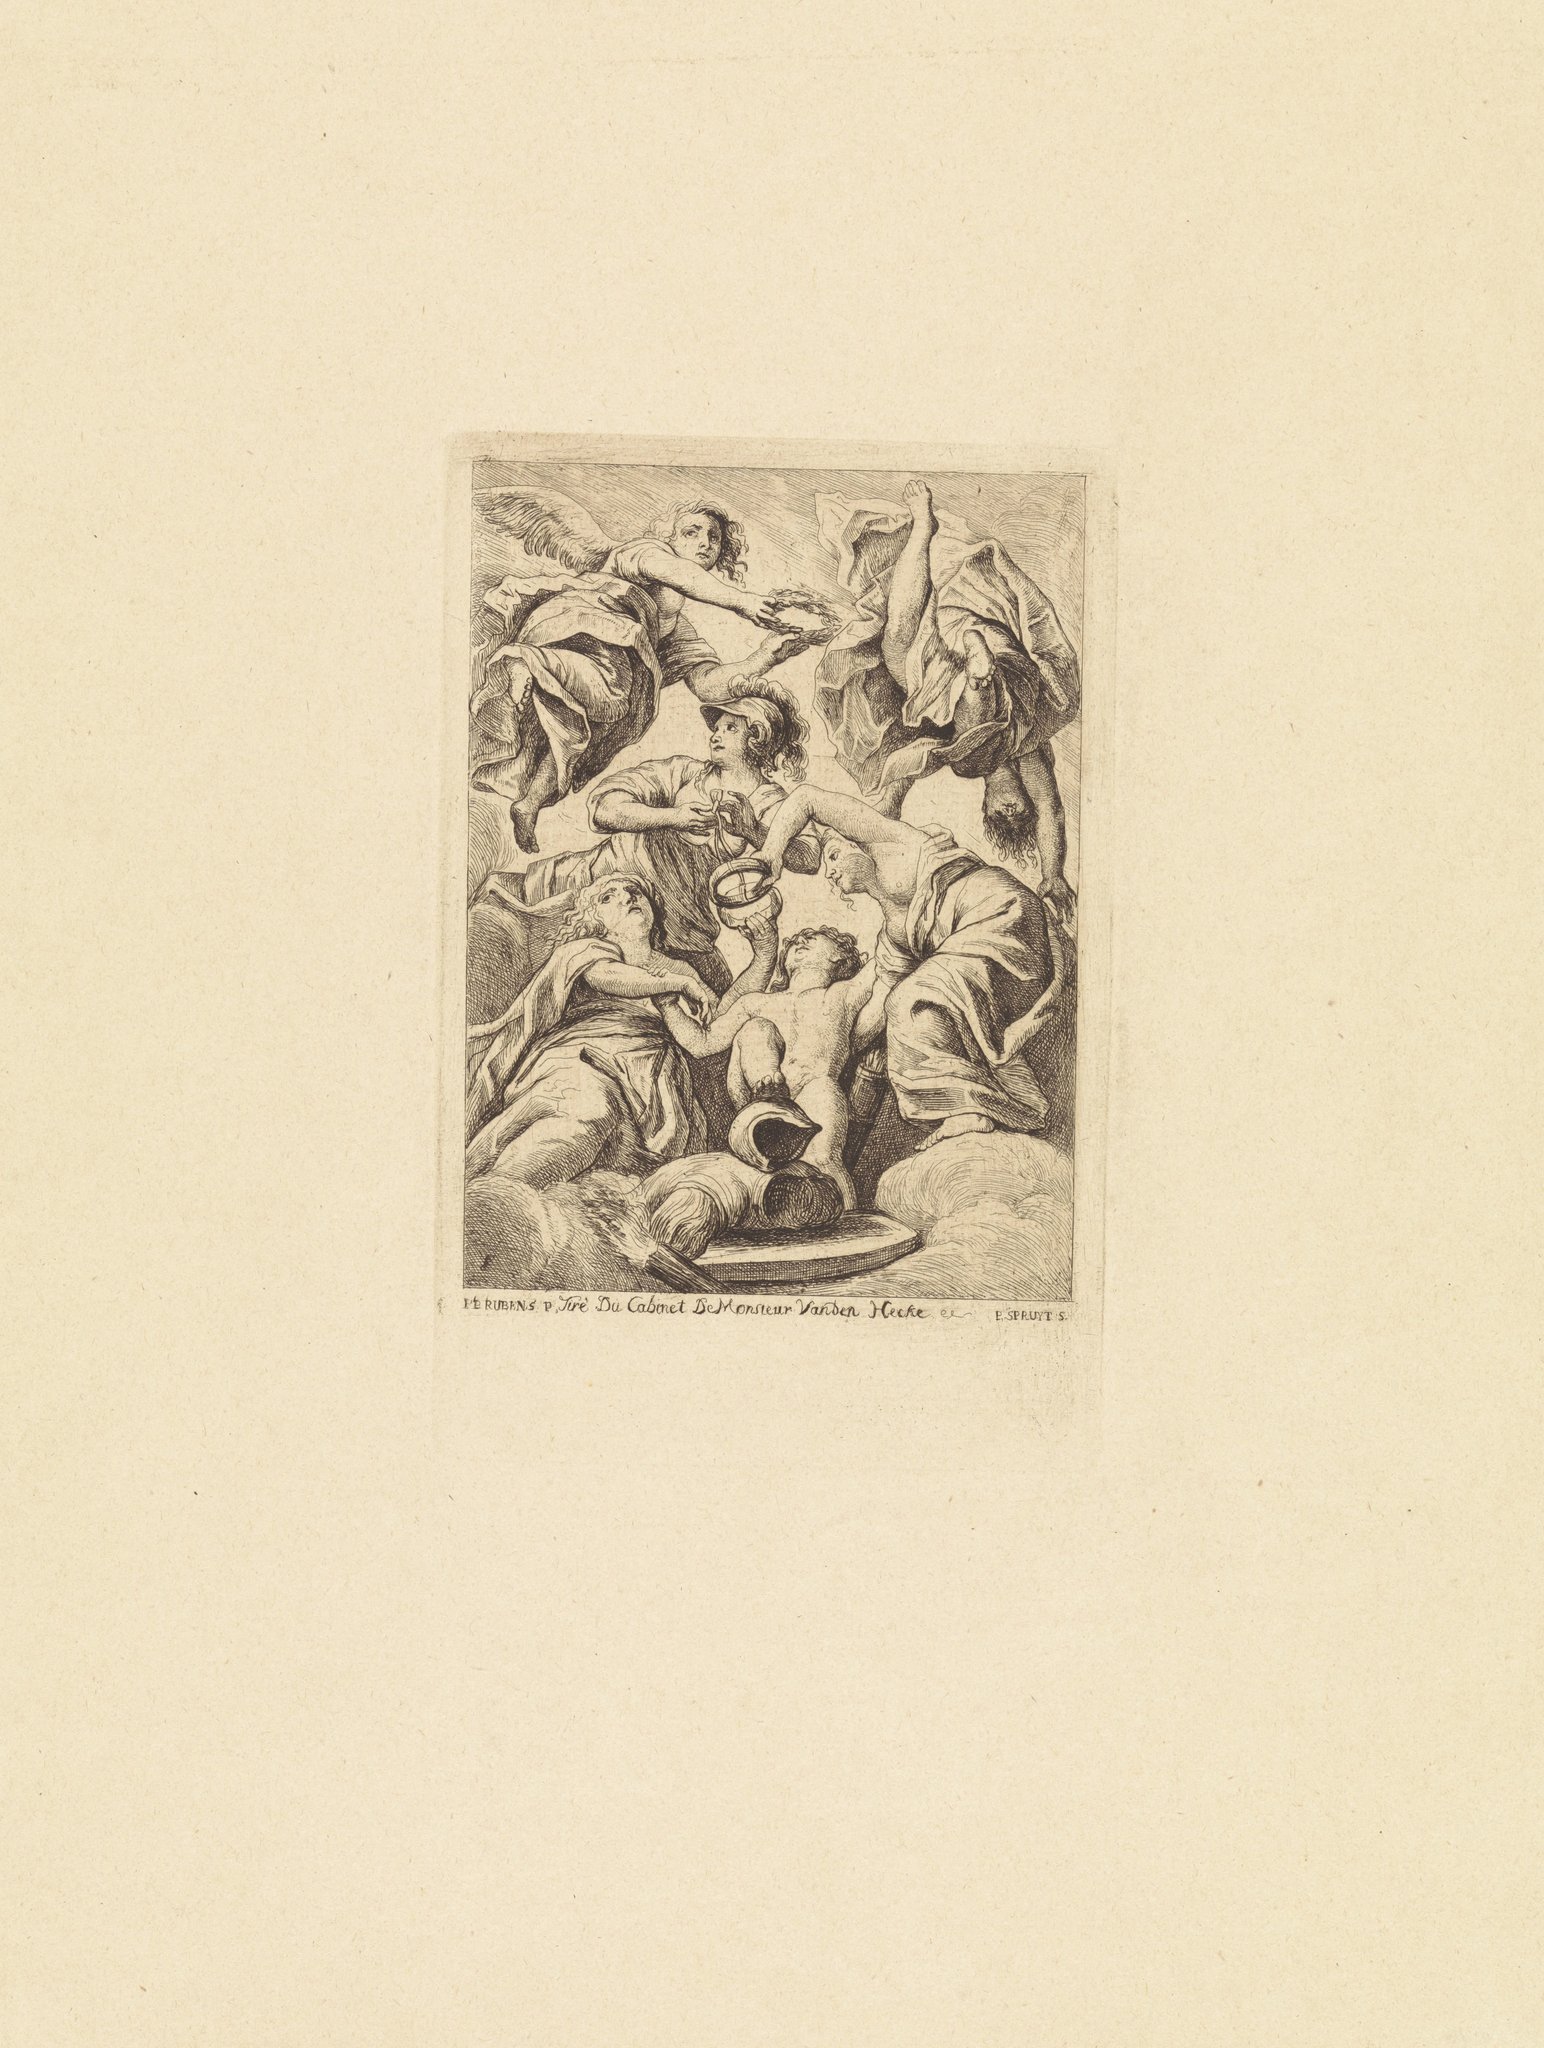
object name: print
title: Vereniging van de kronen van Engeland en Schotland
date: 1747-1801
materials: paper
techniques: etching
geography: ghent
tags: jacobus i (koning van engeland), london, karel i (koning van engeland), (story of) minerva (pallas, athena), crowning the victor with laurel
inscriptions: collector's mark: Lugt 2228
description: Allegorische voorstelling op de regering van James I, koning van Engeland. Minerva verbindt de kronen, in de vorm van ringen, van de personificaties van Engeland en Schotland. Deze twee vrouwelijke personificaties flankeren een kind, dat op een wapenrusting ligt. Dit kind symboliseert het nieuwe koninkrijk en de toekomstige regering van Charles I.